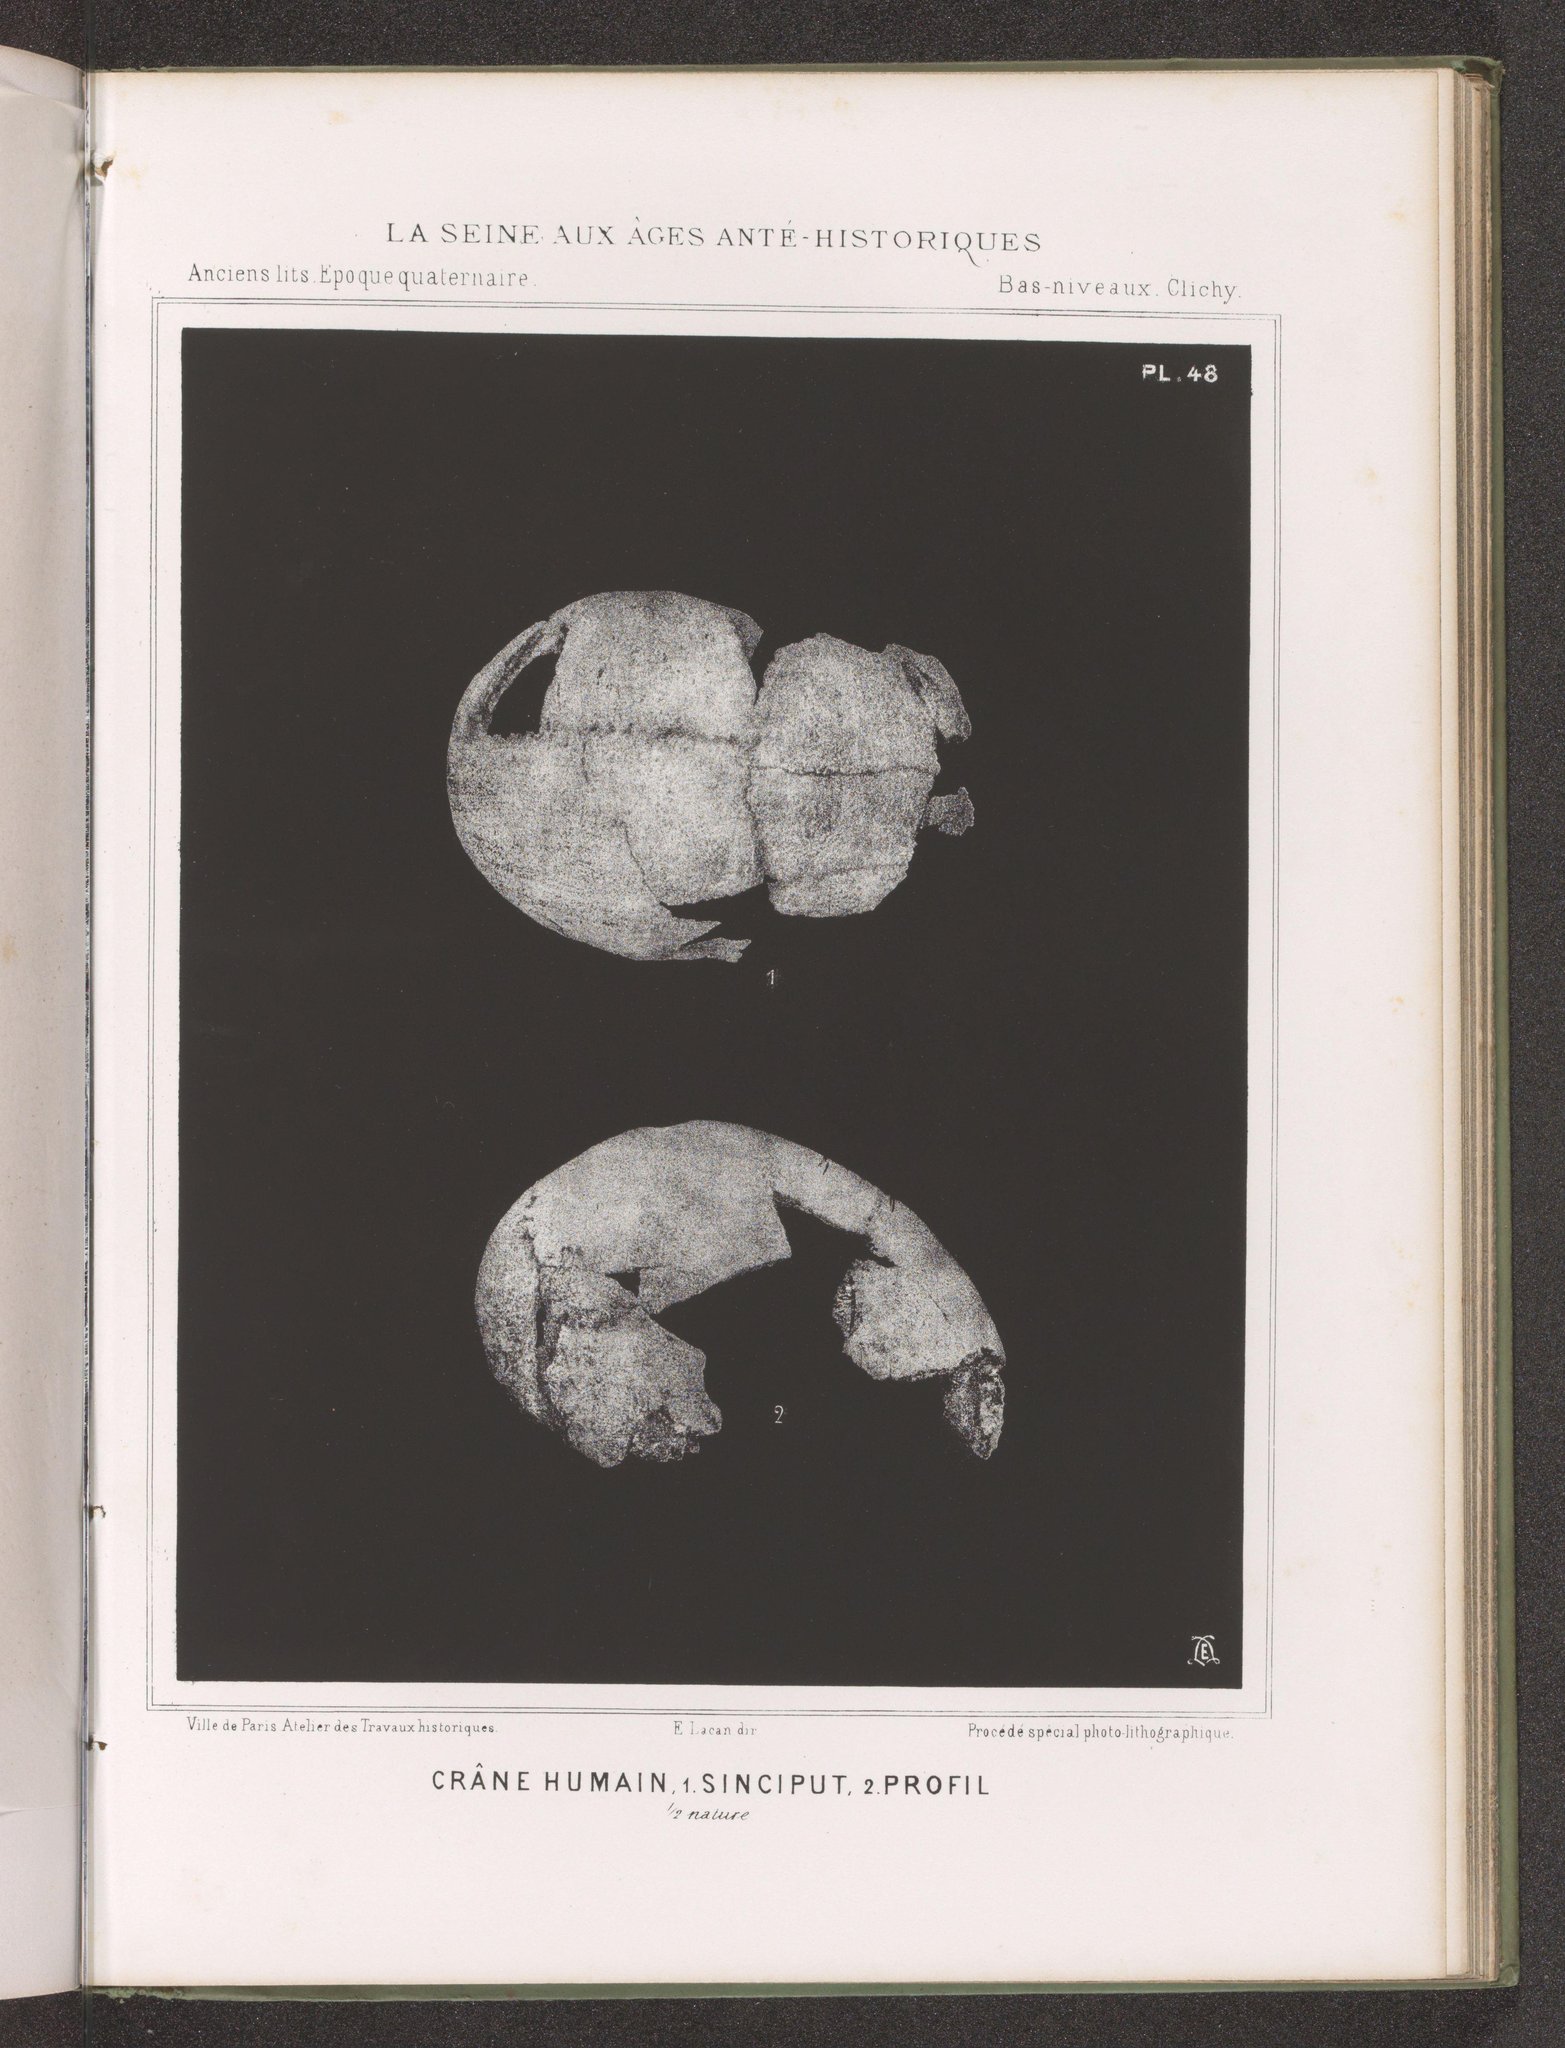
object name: page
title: CRÂNE HUMAIN. 1. SINCIPUT, 2. PROFIL 1/2 nature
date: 1860-1869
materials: paper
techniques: photolithography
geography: france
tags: animals (+ skeleton of an animal), palaeontology, france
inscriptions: number: ‘Pl. 48’, inscription: ‘Ville de Paris. Atelier des Travaux historiques. E. Lacan dir. Procédé spécial photo-lithographique.’, monogram: ‘LEL’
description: Voor plek prent in boek: zie nummer onder 'Opschriften / Merken'.